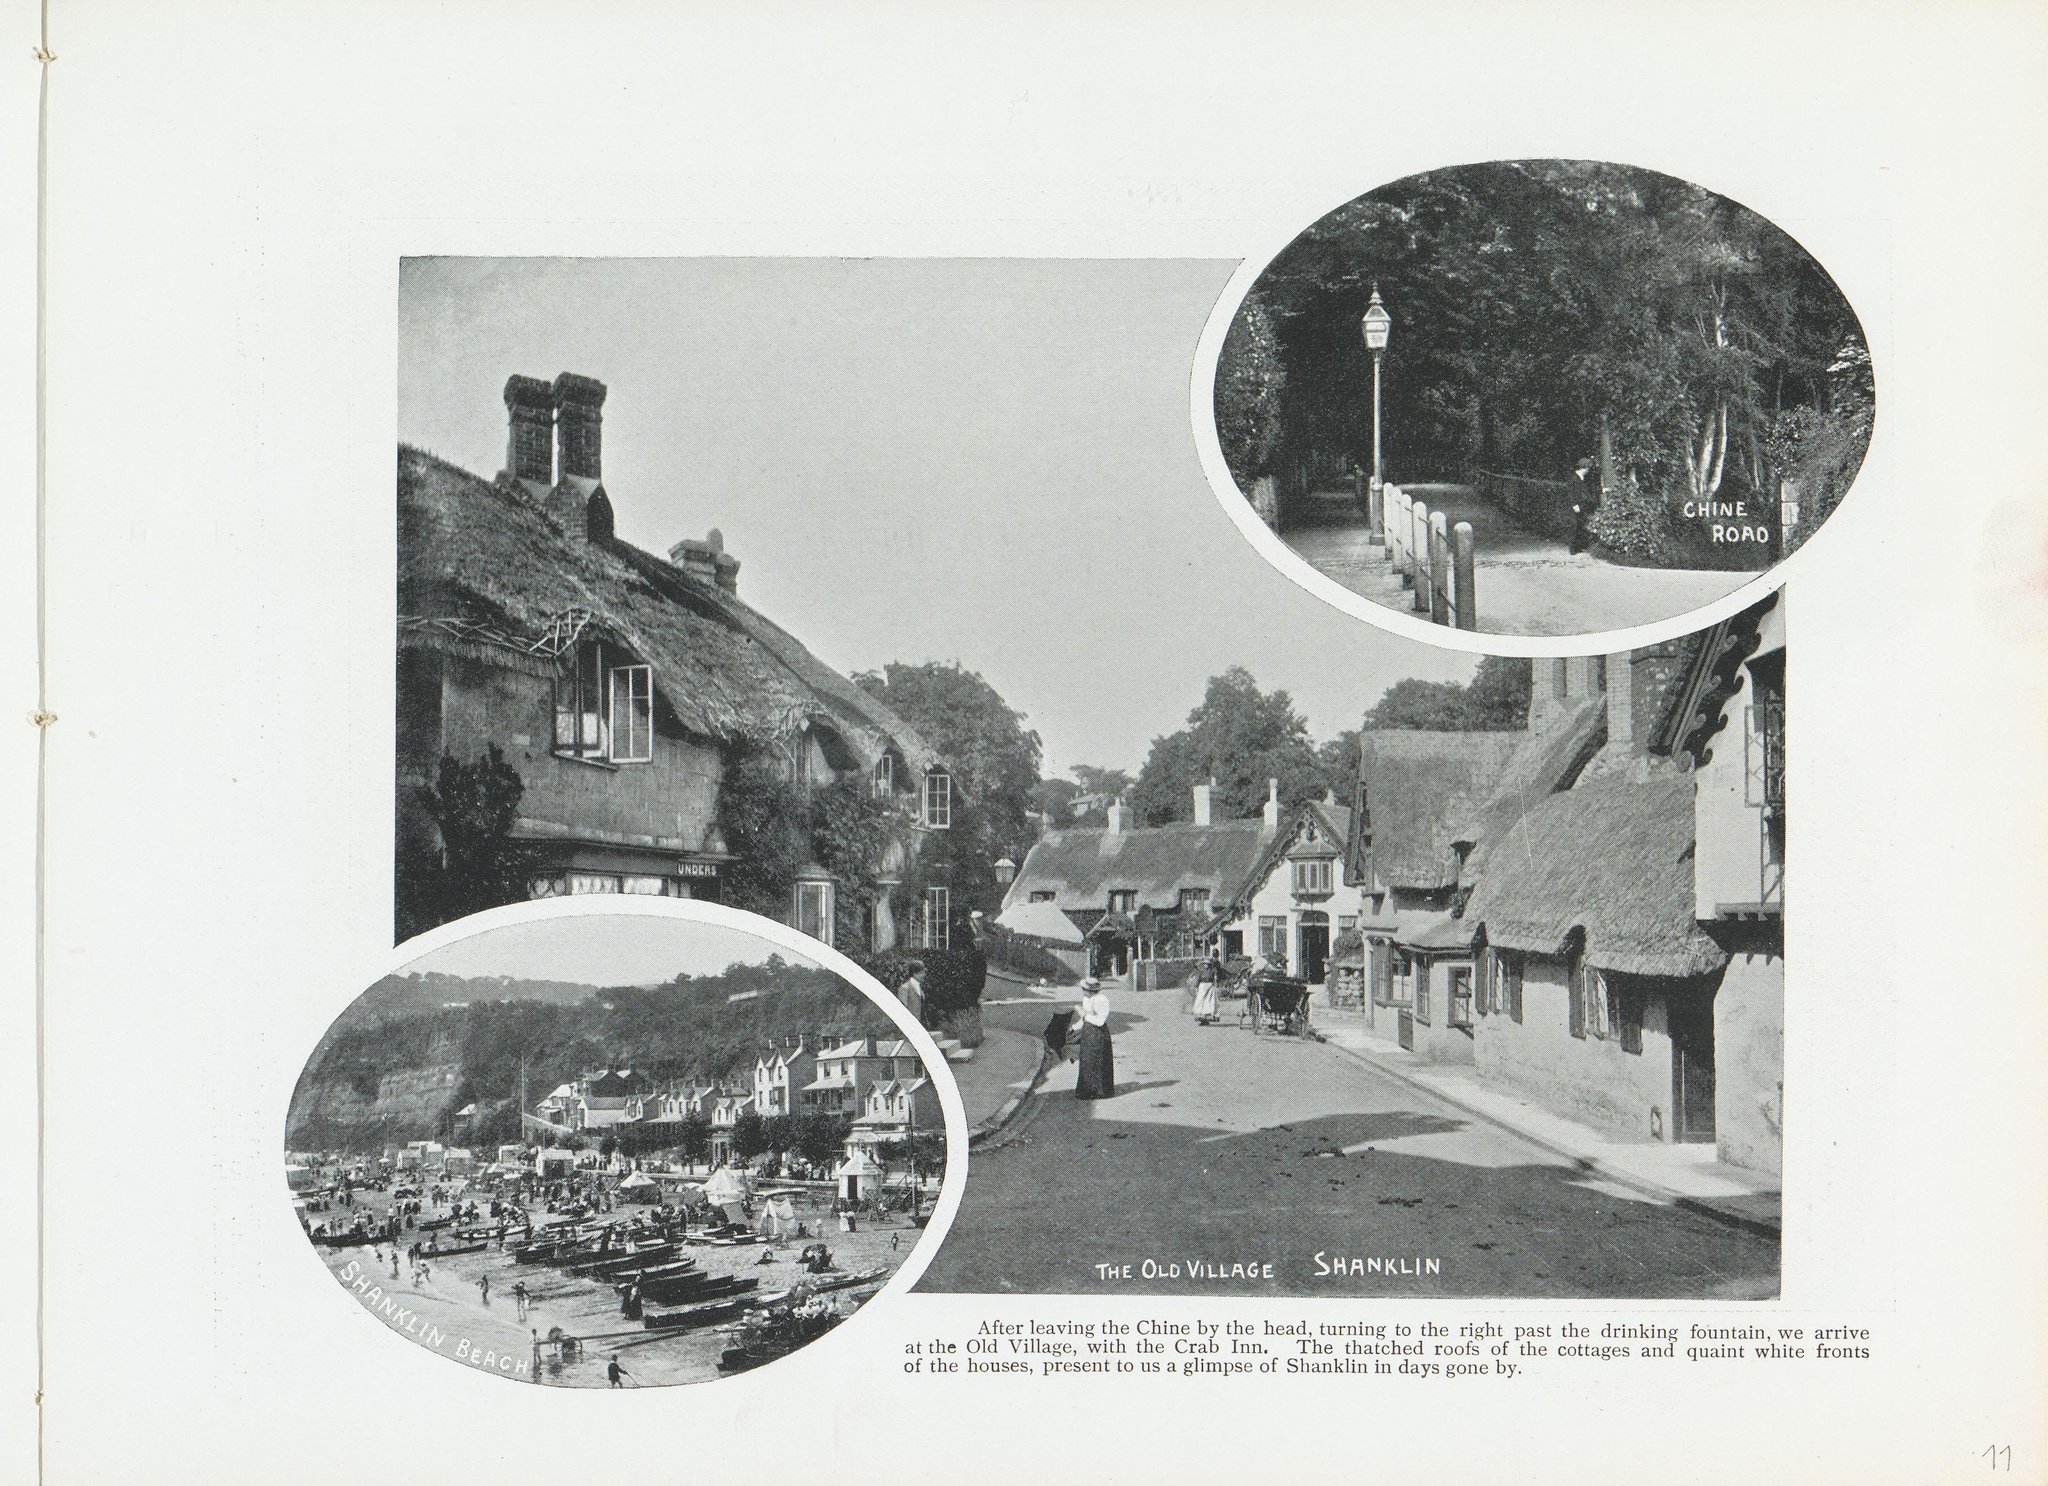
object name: photograph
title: Shanklin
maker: Anonymous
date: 1897-1930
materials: paper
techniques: printing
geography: isle of wight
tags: beach (as place of recreation), public road in village, travelling; tourism, isle of wight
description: Pagina 11 met 3 foto's van het strand, Chine Road en een dorpsstraat in Shanklin en een bijschrift. Onderdeel van Fotografische reisreportage van het eiland Wight.